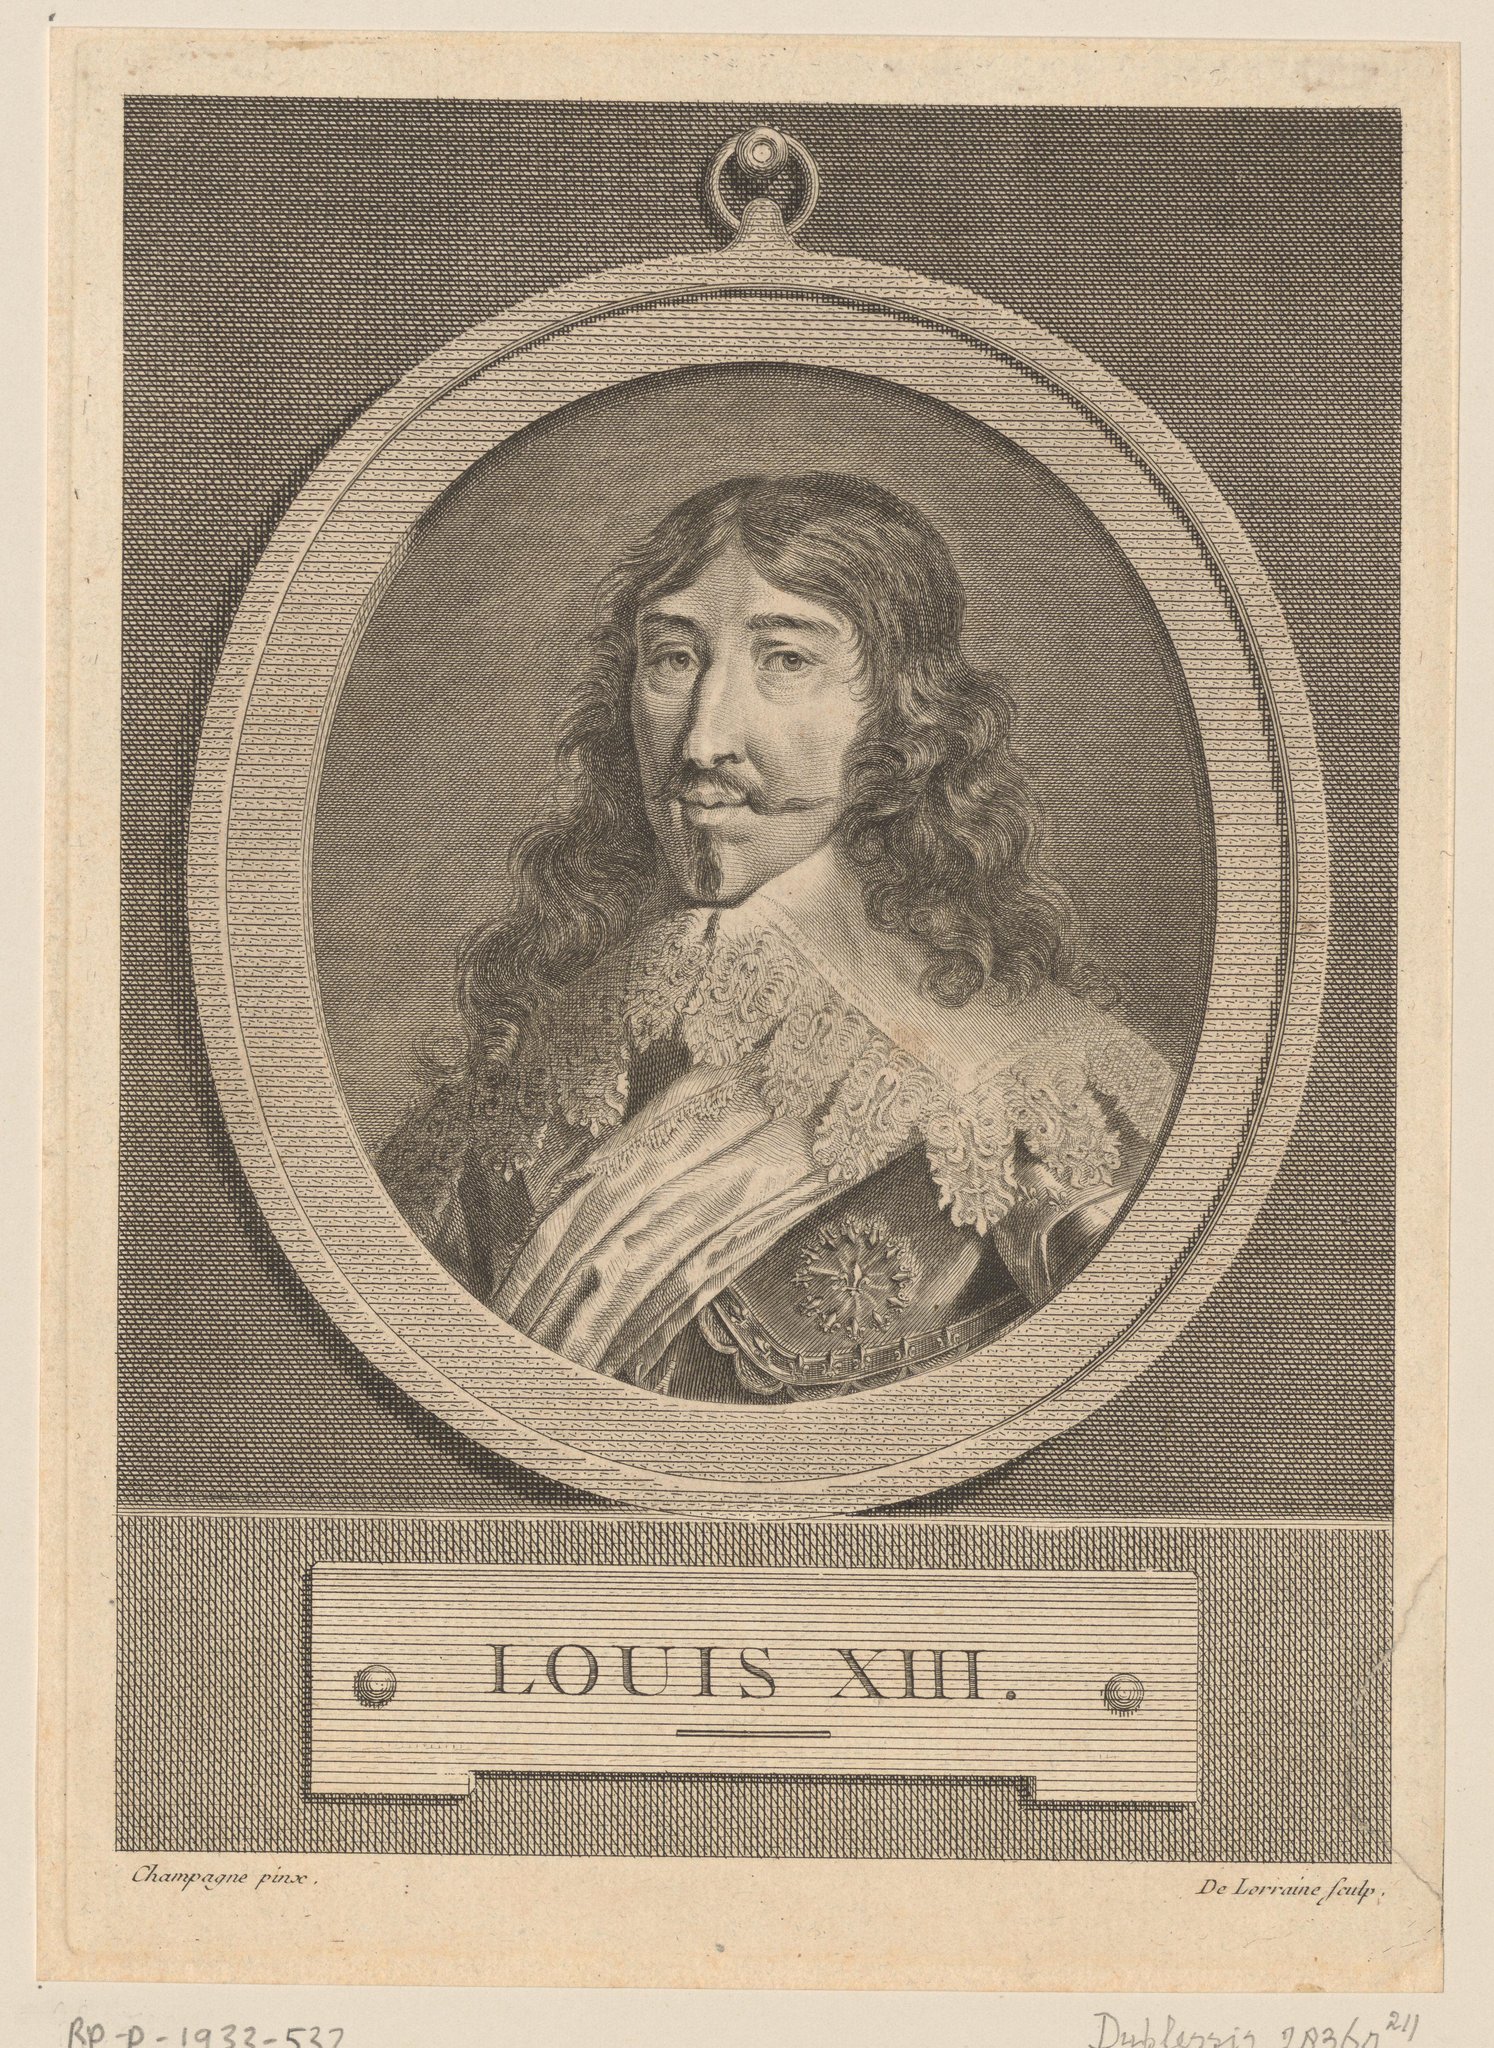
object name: print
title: Portret van Lodewijk XIII van Frankrijk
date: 1747-1799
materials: paper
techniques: engraving, etching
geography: france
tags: lodewijk xiii (koning van frankrijk), ornament ~ medallion, historical persons, king